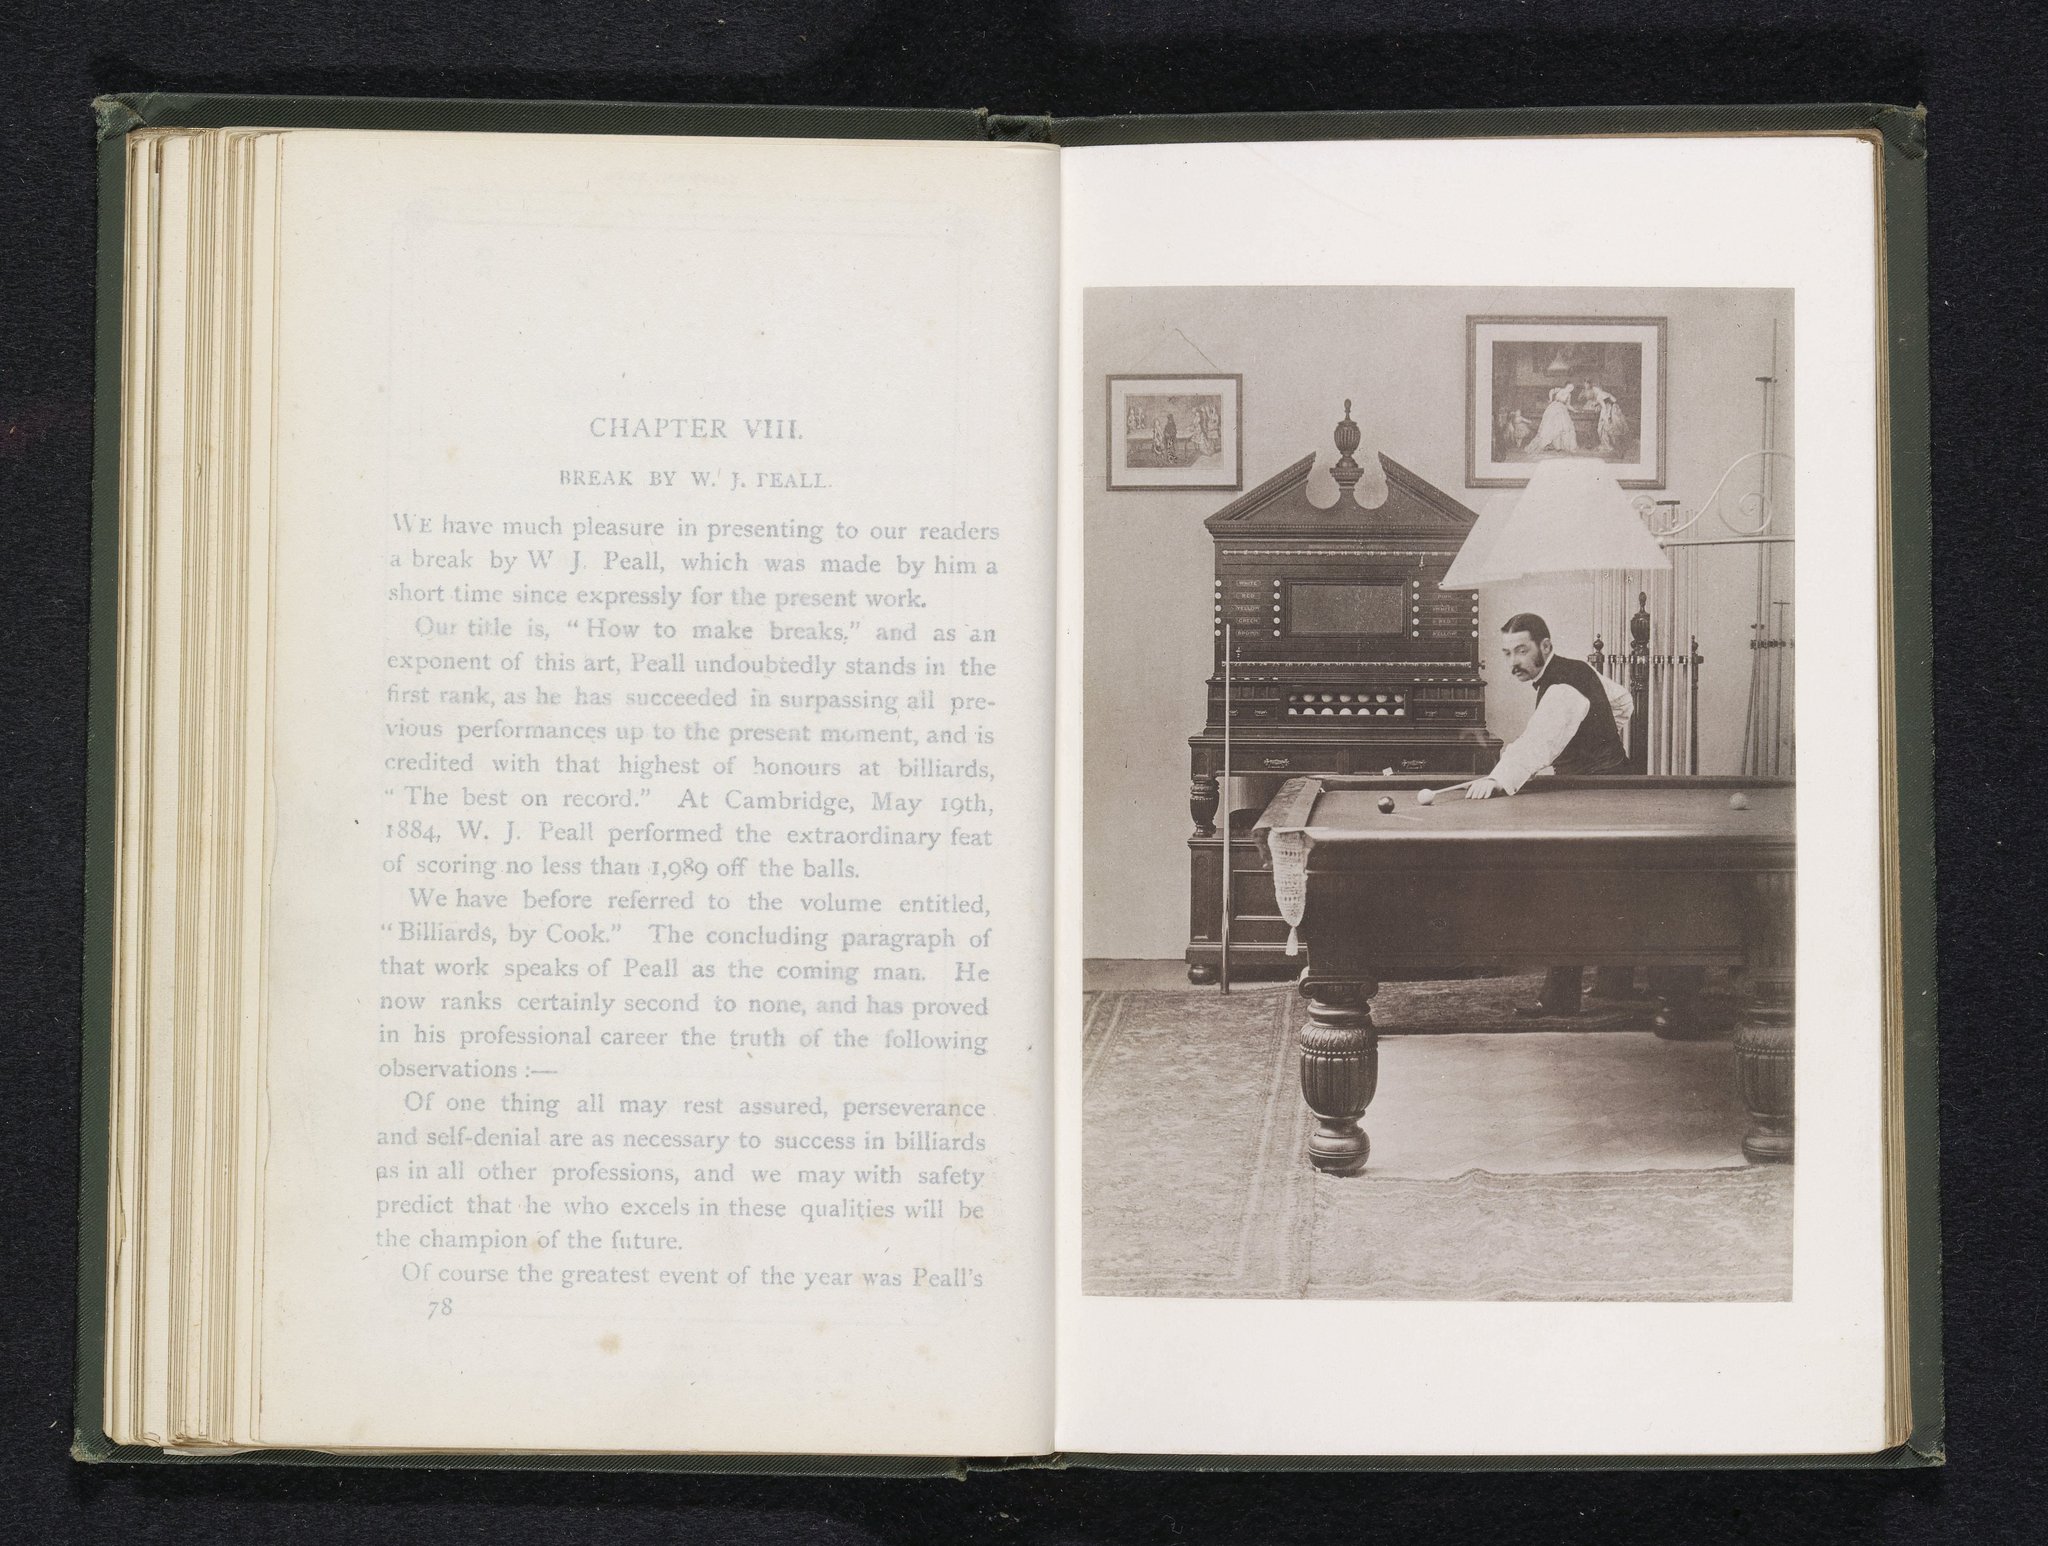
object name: photomechanical print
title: Man speelt biljart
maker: Anonymous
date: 1875-1885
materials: paper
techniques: photograph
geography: great britain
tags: billiards, billiards (+ sportsman, player, etc.), interior ~ representation of a building